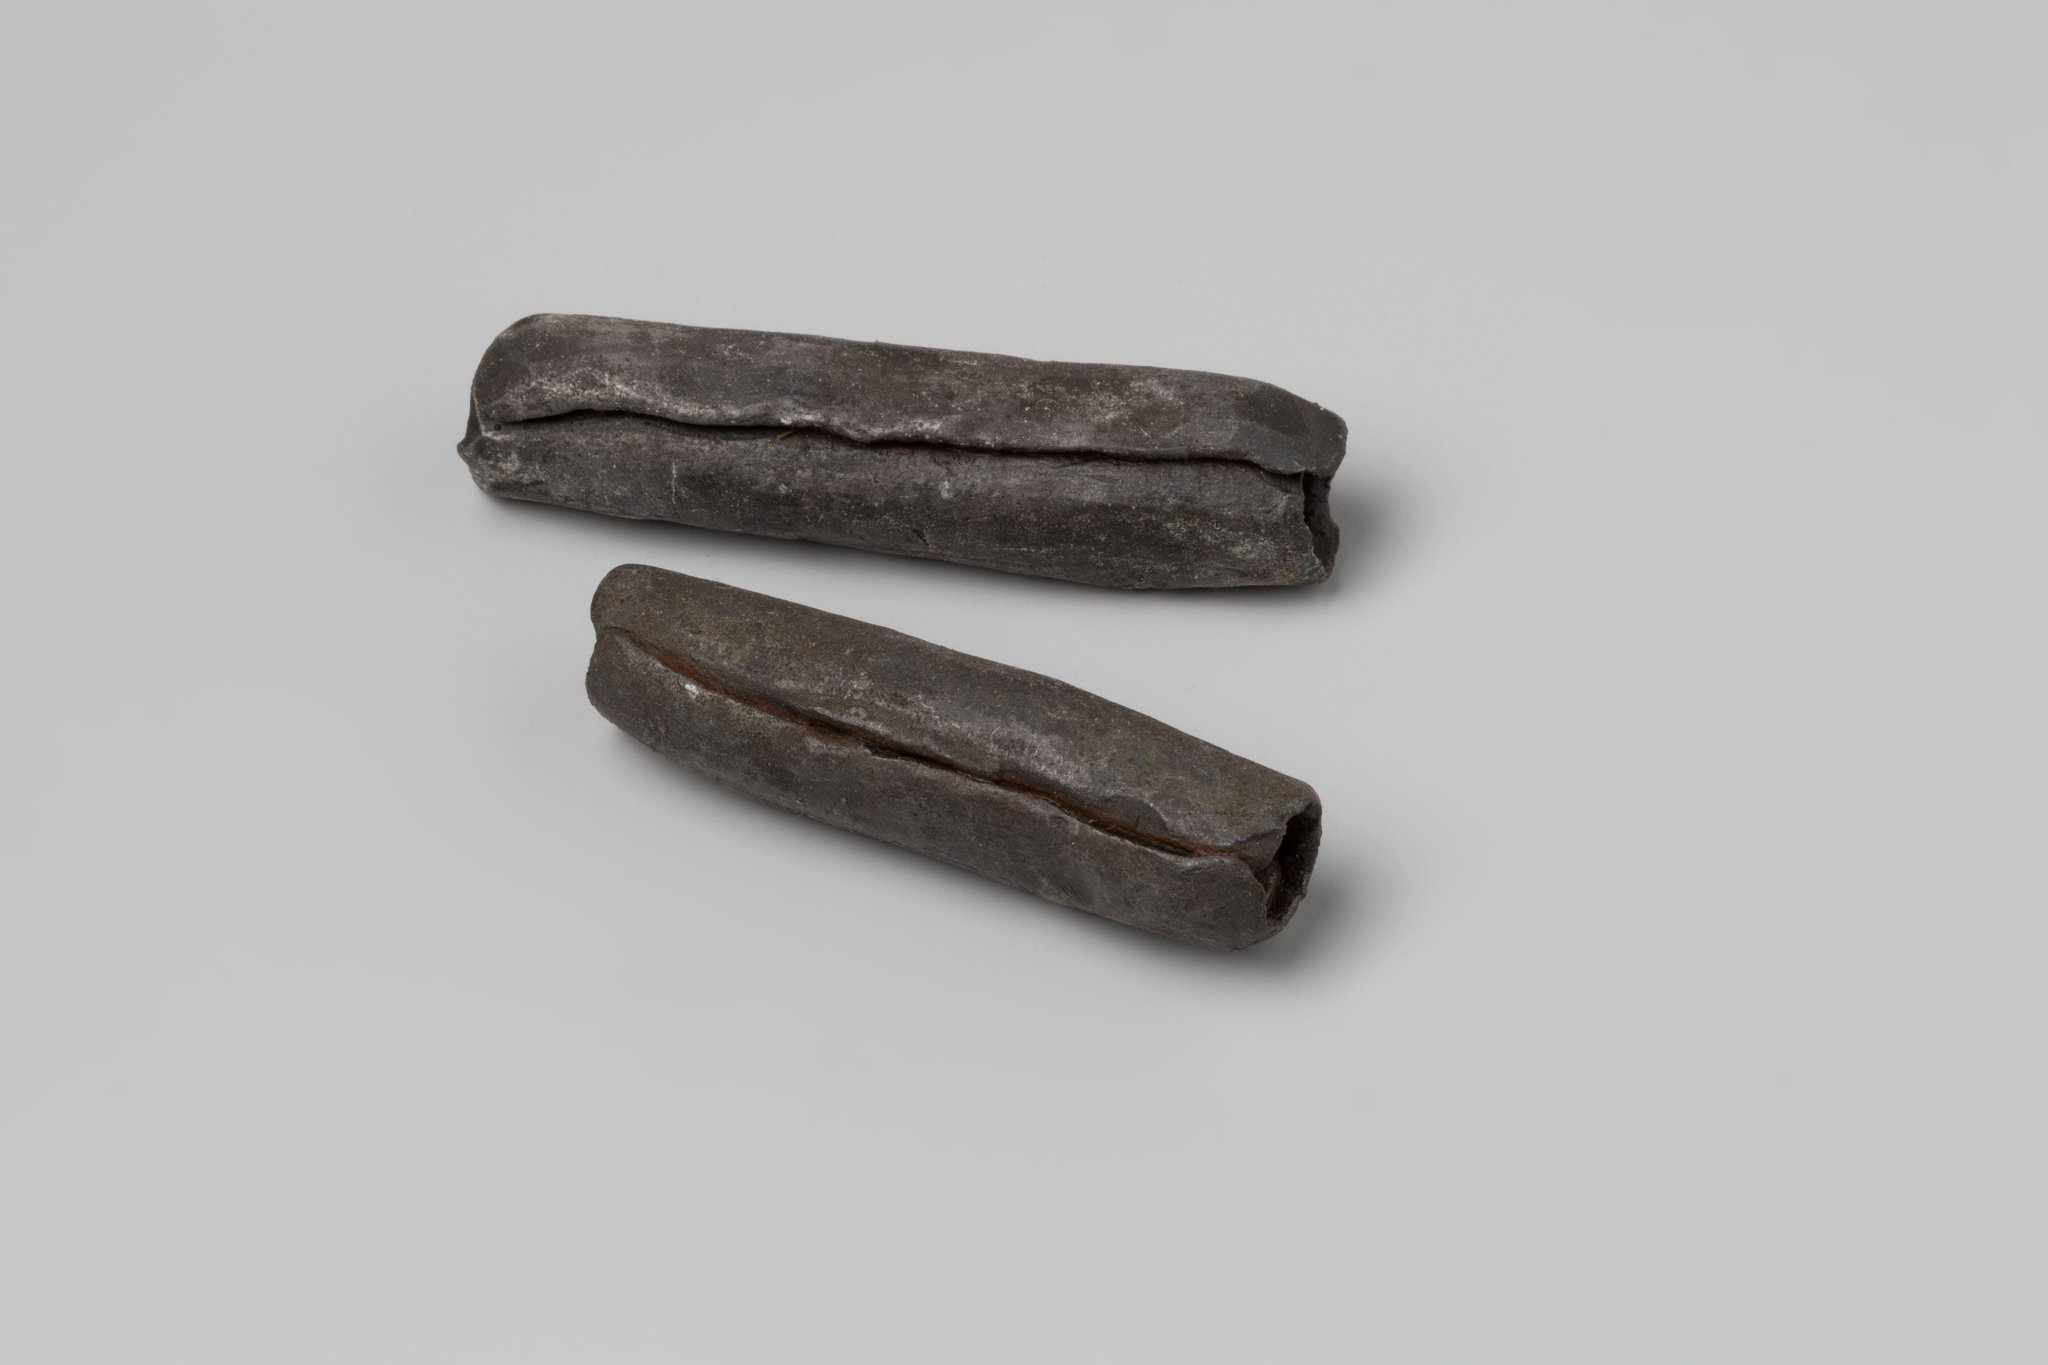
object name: lead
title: Loden rol uit het wrak van de Oost-Indiëvaarder 't Vliegend Hart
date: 1700-1735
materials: lead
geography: middelburg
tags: 't vliegend hart (schip), verenigde oostindische compagnie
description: Deze loden buisjes zijn vermoedelijk afkomstig van visnetten ofwel op TVliegend Hart zelf ofwel van vissers die hun netten aan het wrak verloren.